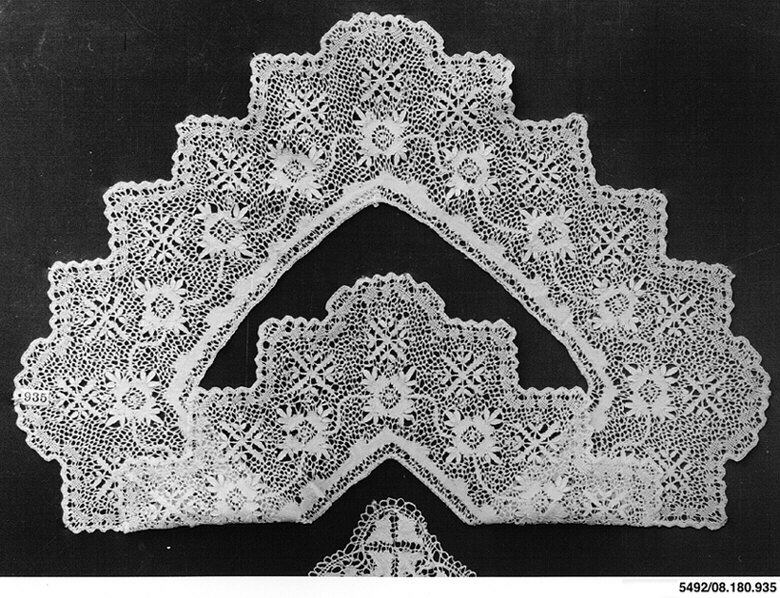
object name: handkerchief border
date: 1801-1900